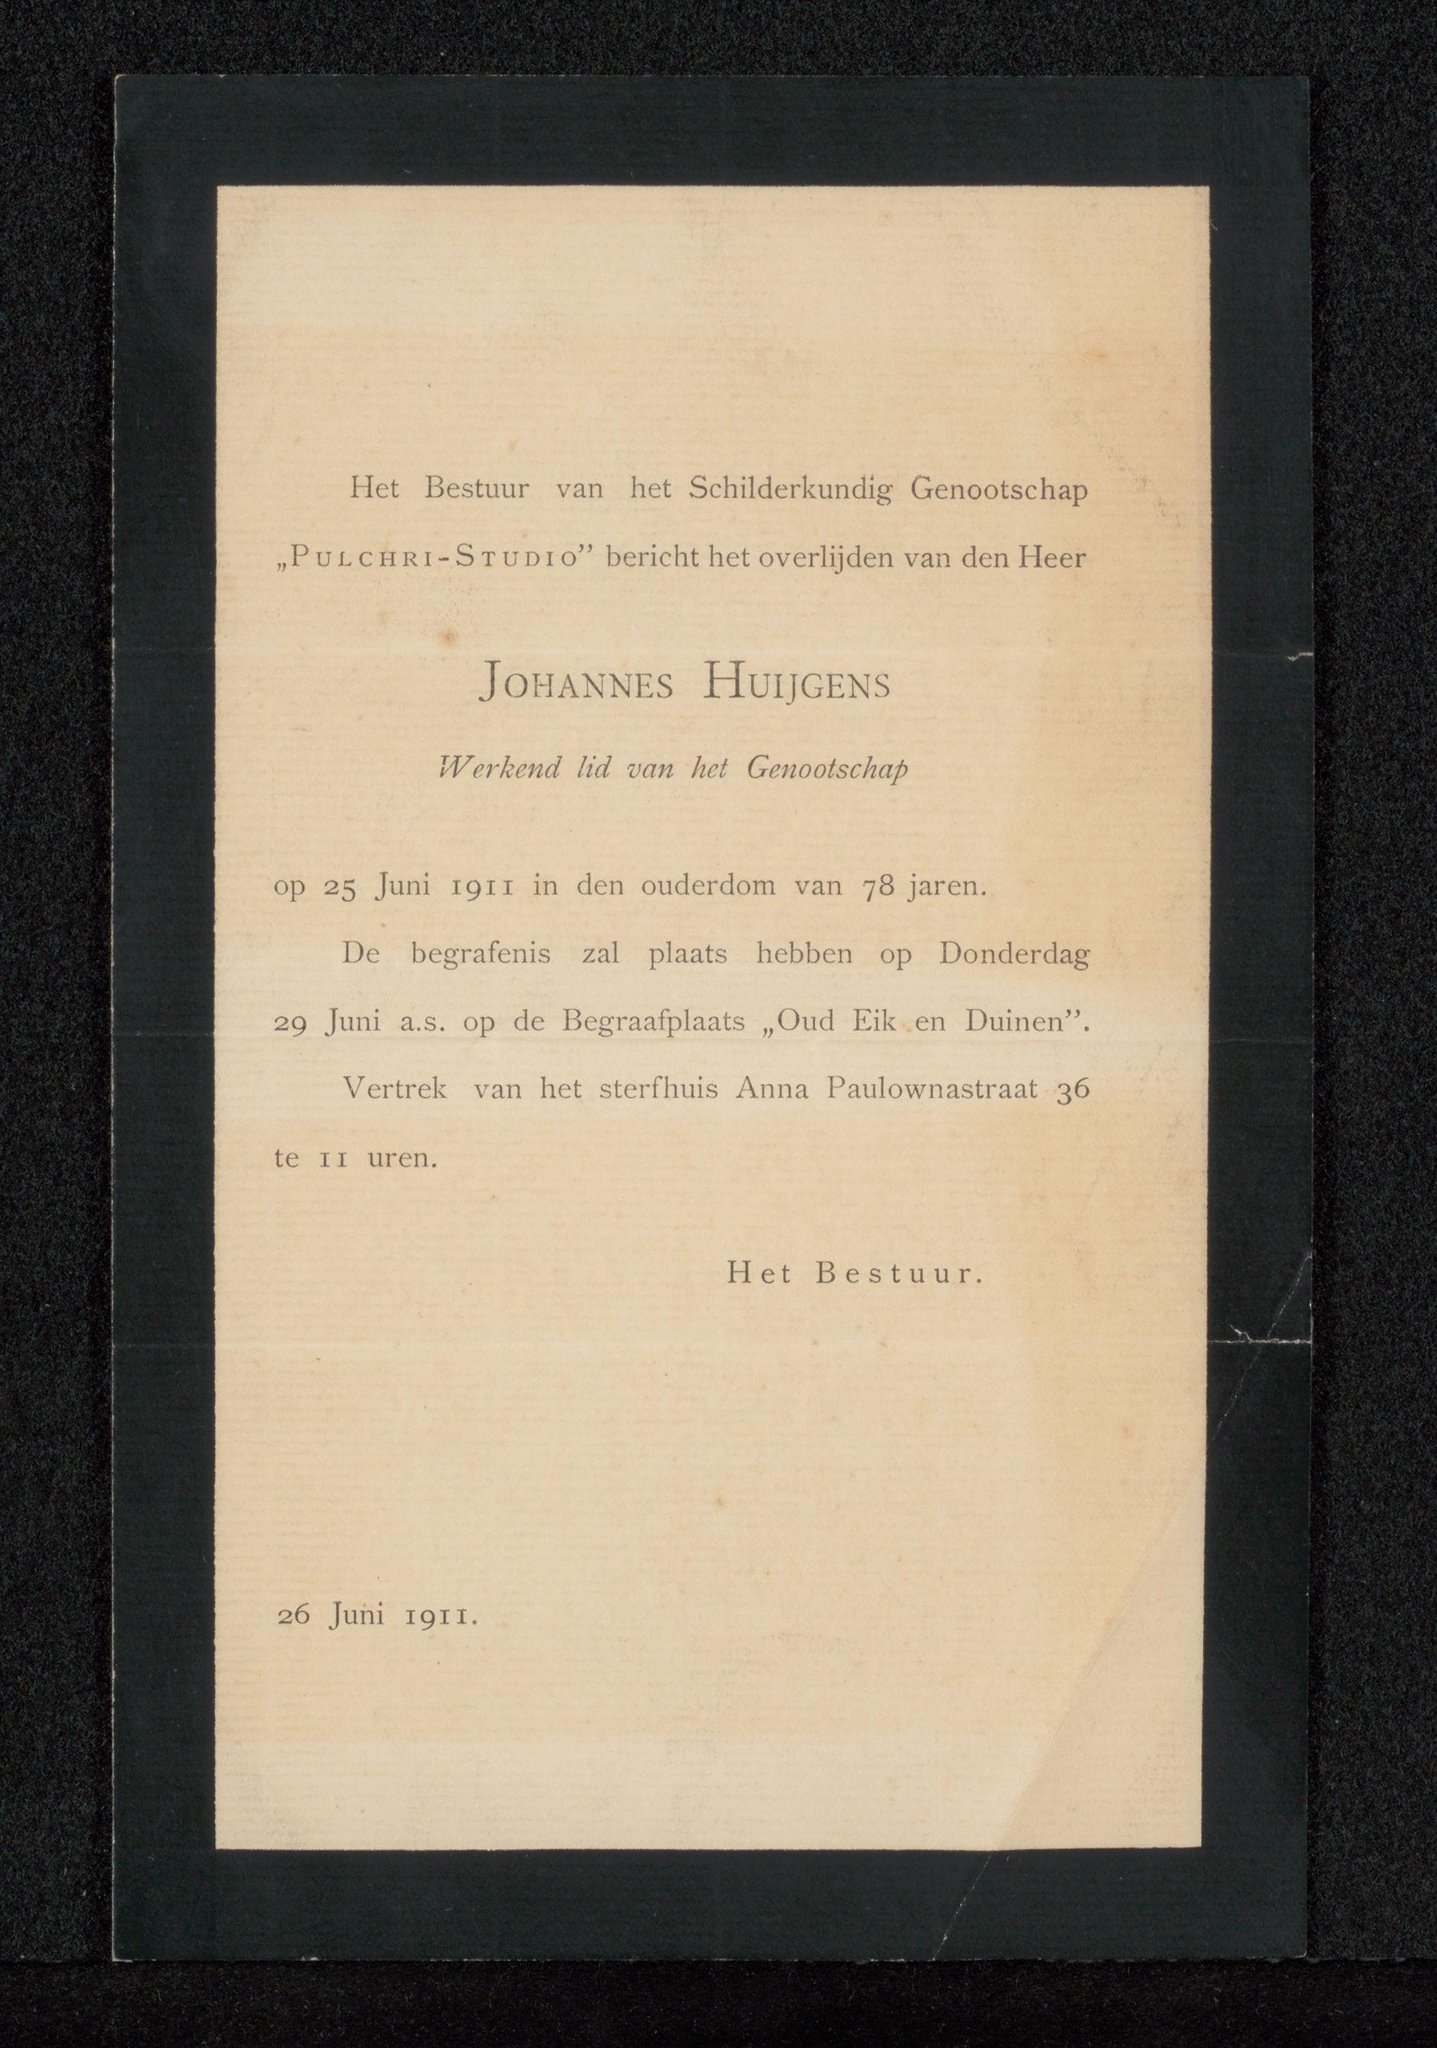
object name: overlijdensbericht, overlijdensadvertentie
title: Overlijdensbericht aan Philip Zilcken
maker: Anonymous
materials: paper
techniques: printing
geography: the hague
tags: johannes huygens, the hague, painter, philip zilcken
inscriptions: collector's mark: ‘RPK’